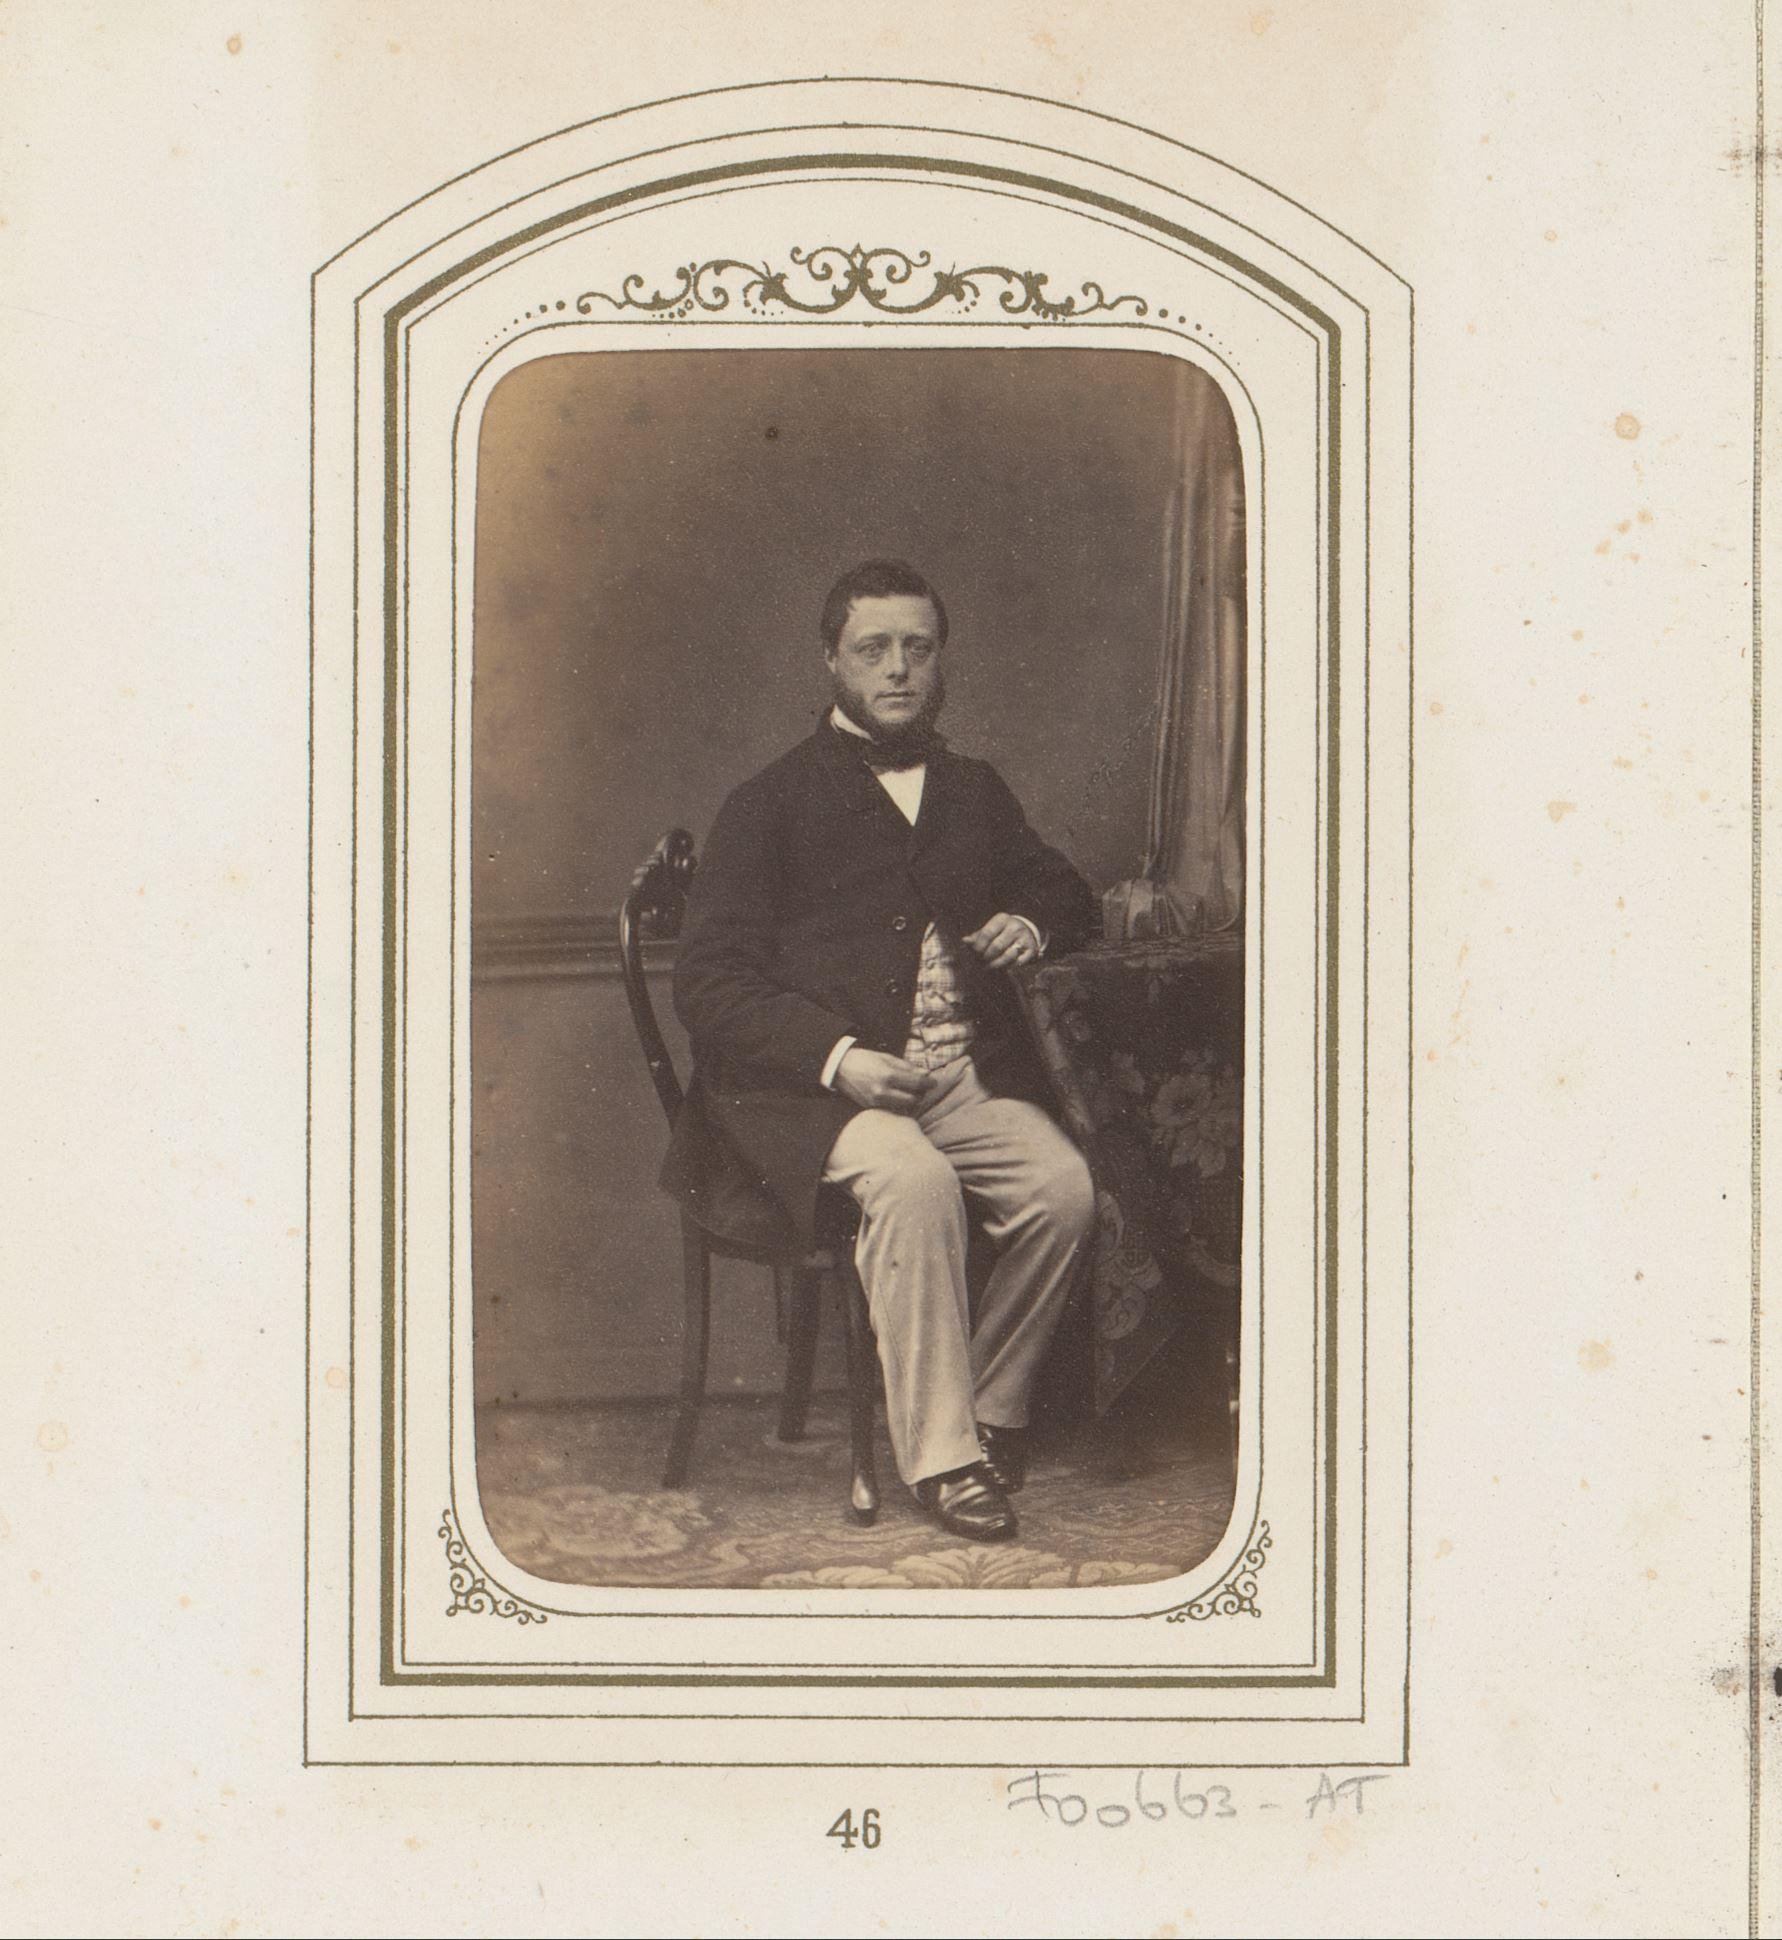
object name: album leaf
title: Portret van een zittende man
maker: Anonymous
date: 1860-1880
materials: cardboard, photographic support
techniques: albumen print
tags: historical persons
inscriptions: number: ‘46’